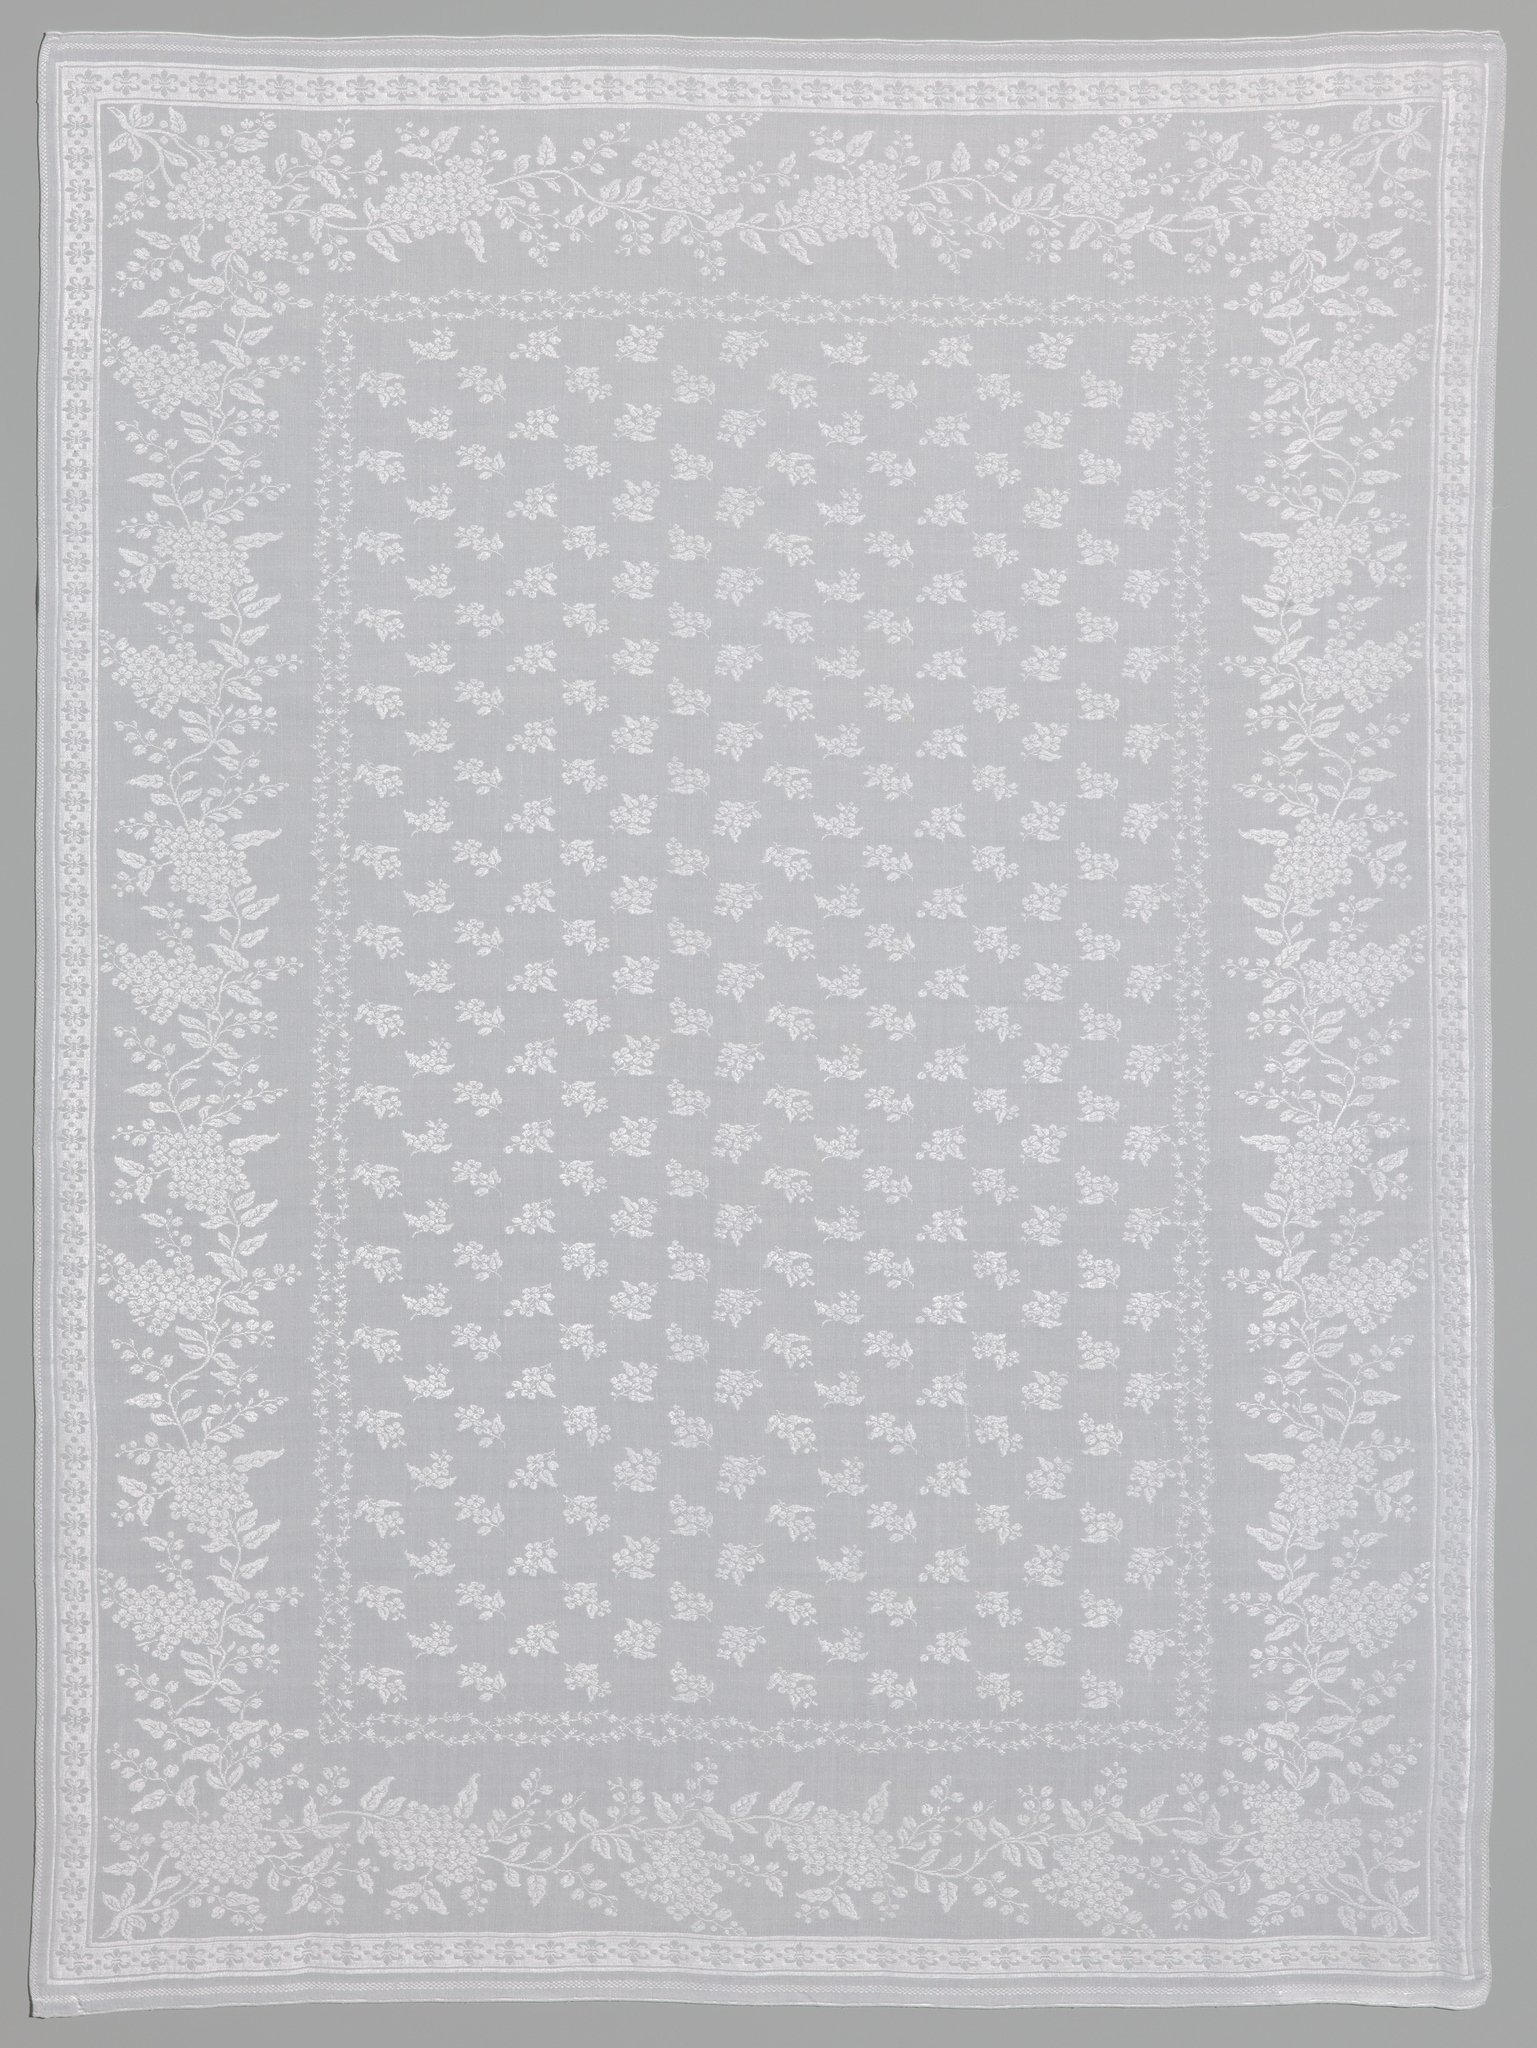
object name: napkin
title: Servet met strooibloemen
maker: Anonymous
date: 1700-1899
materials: linen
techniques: damask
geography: saxony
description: Vergelijk E. Kumsch, Leinendamastmuster des XVII. und XVIII. Jahrhunderts, Dresden 1891, Taf. 9,1.